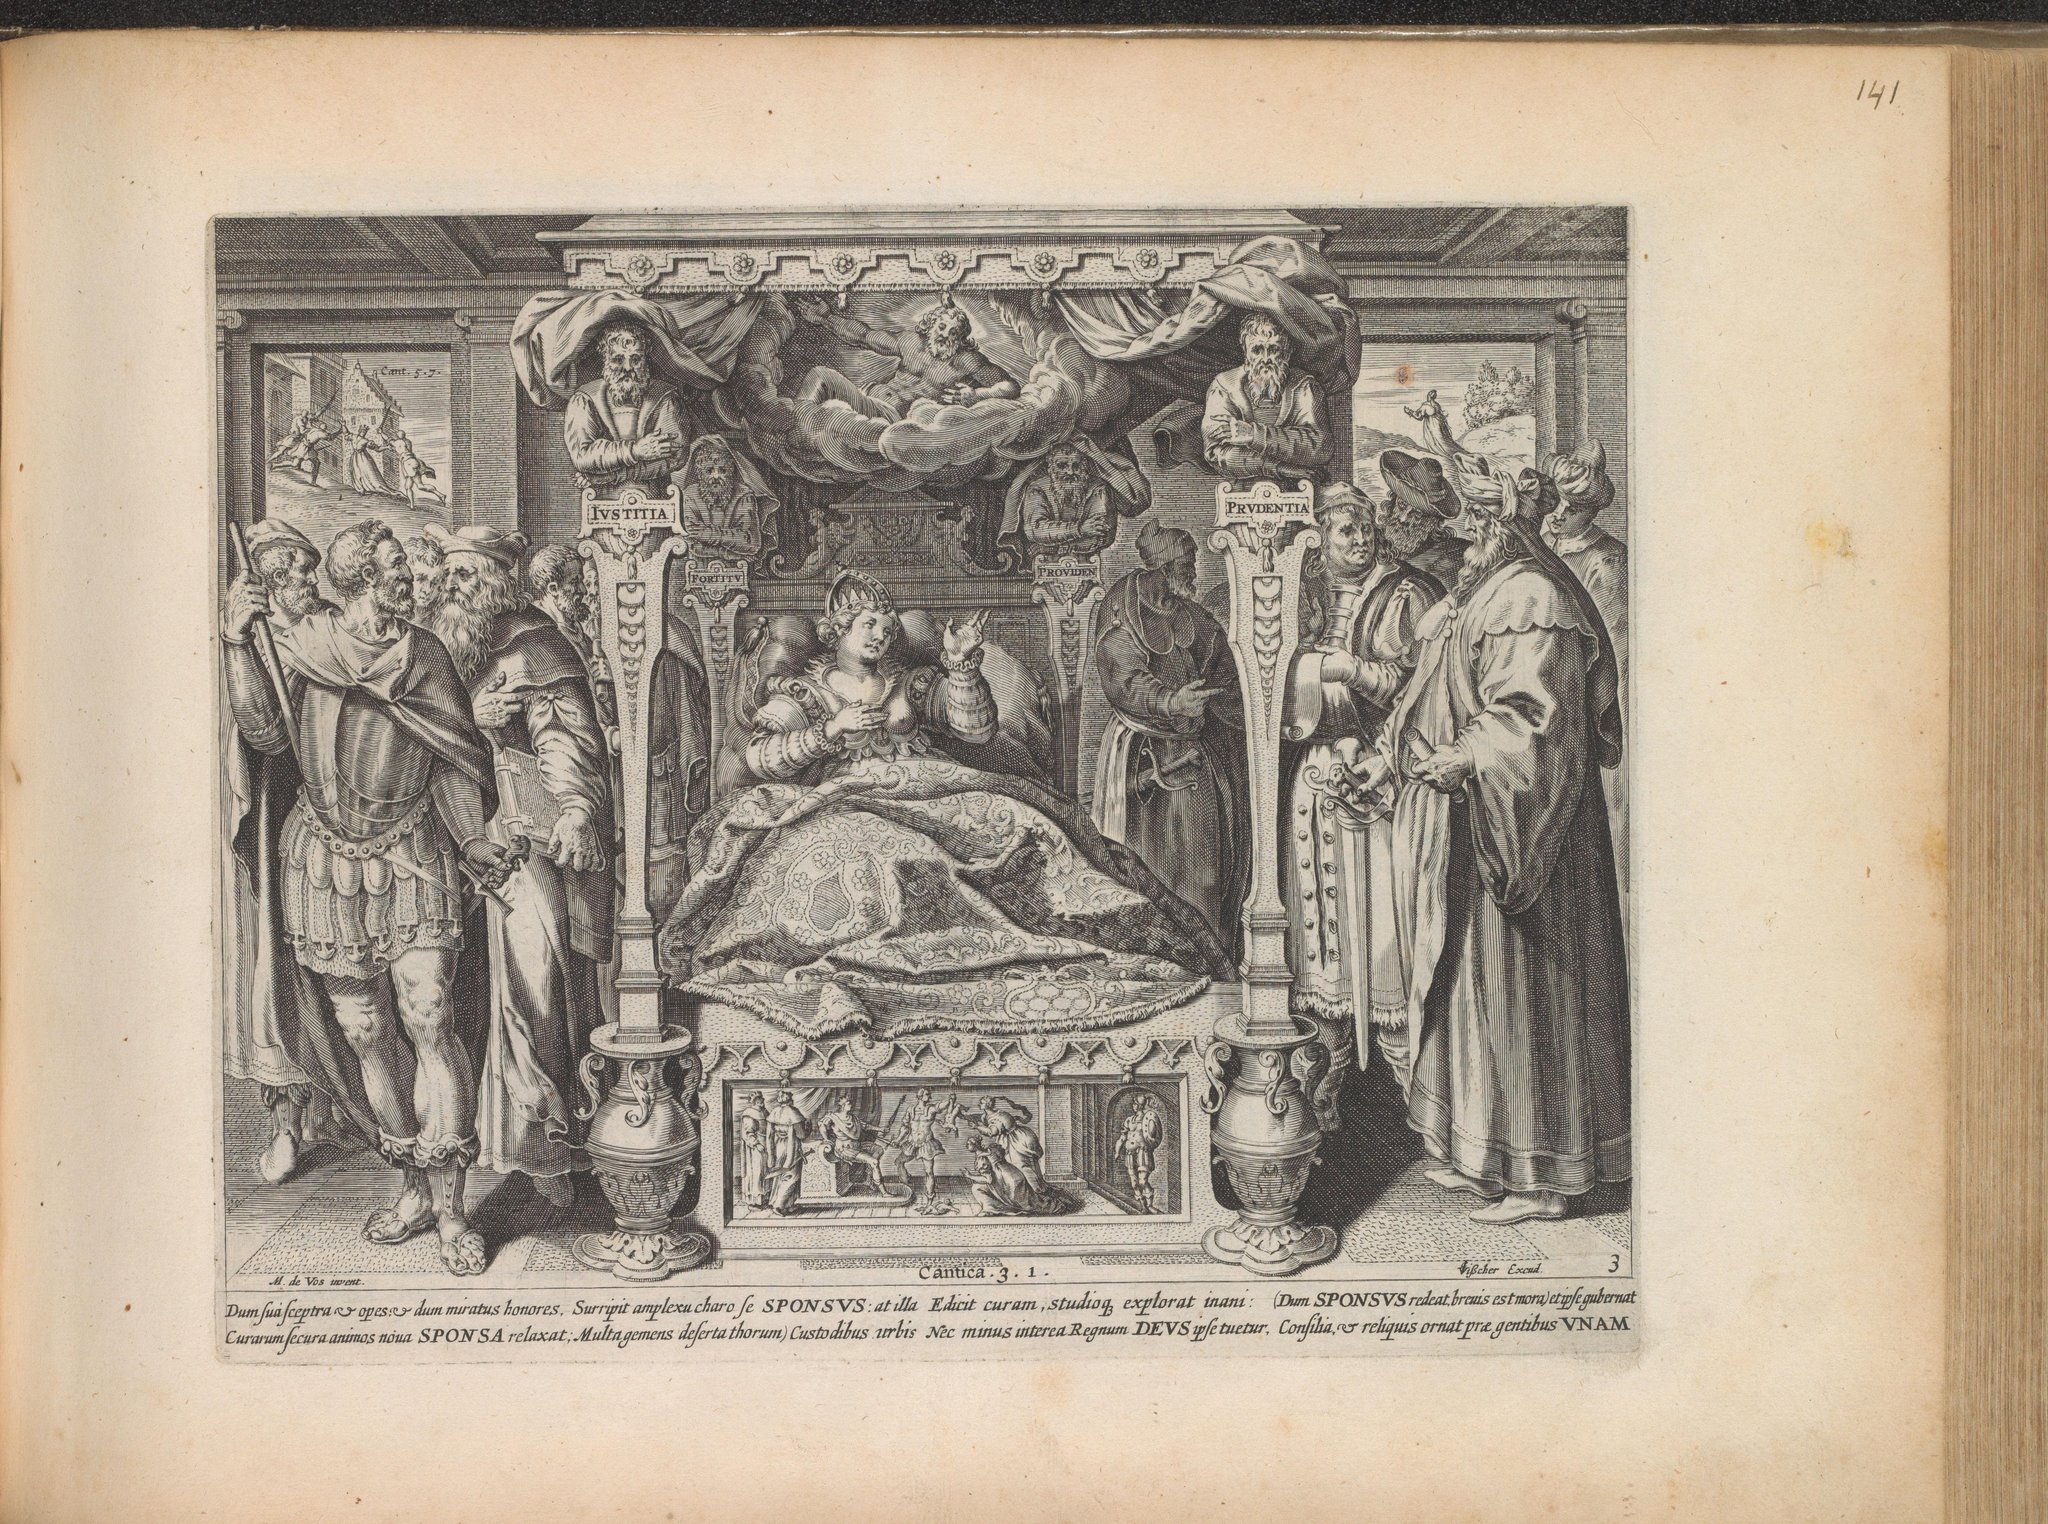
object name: print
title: Bed met de bruid van Christus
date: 1643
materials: paper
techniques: engraving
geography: amsterdam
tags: fortitude, 'fortitudo' ~ one of the four cardinal virtues, 'ecclesia' as bride of christ (the lamb), 'ecclesia sponsa dei', 'sponsus-sponsa', song of solomon, song of songs (with book chapter:verse) (+ christ bearded), the judgement of solomon (1 kings 3:16-28), justice, 'justitia'; 'giustitia divina' (ripa) ~ one of the four cardinal virtues, prudence, 'prudentia'; 'prudenza' (ripa) ~ one of the four cardinal virtues, caryatids ~ architecture, bed with tester, forethought, deliberation; 'previdenza', 'providenza' (ripa), groups of persons from the old testament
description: De bruid van Christus (de kerk) in een bed met een baldakijn. Het baldakijn wordt gedragen door de kardinale deugden. Op het voeteneind een voorstelling van het oordeel van Salomo. Boven het hoofd van de bruid Christus in een wolk. Rond het bed figuren uit het Oude Testament. Op de achtergrond door een deuropening is de bruid van Christus te zien die in de stad op zoek is naar haar lief. Onder de voorstelling een verwijzing in het Latijn naar de Bijbeltekst in Hoogl. 3:1. Deze prent maakt deel uit van een album.